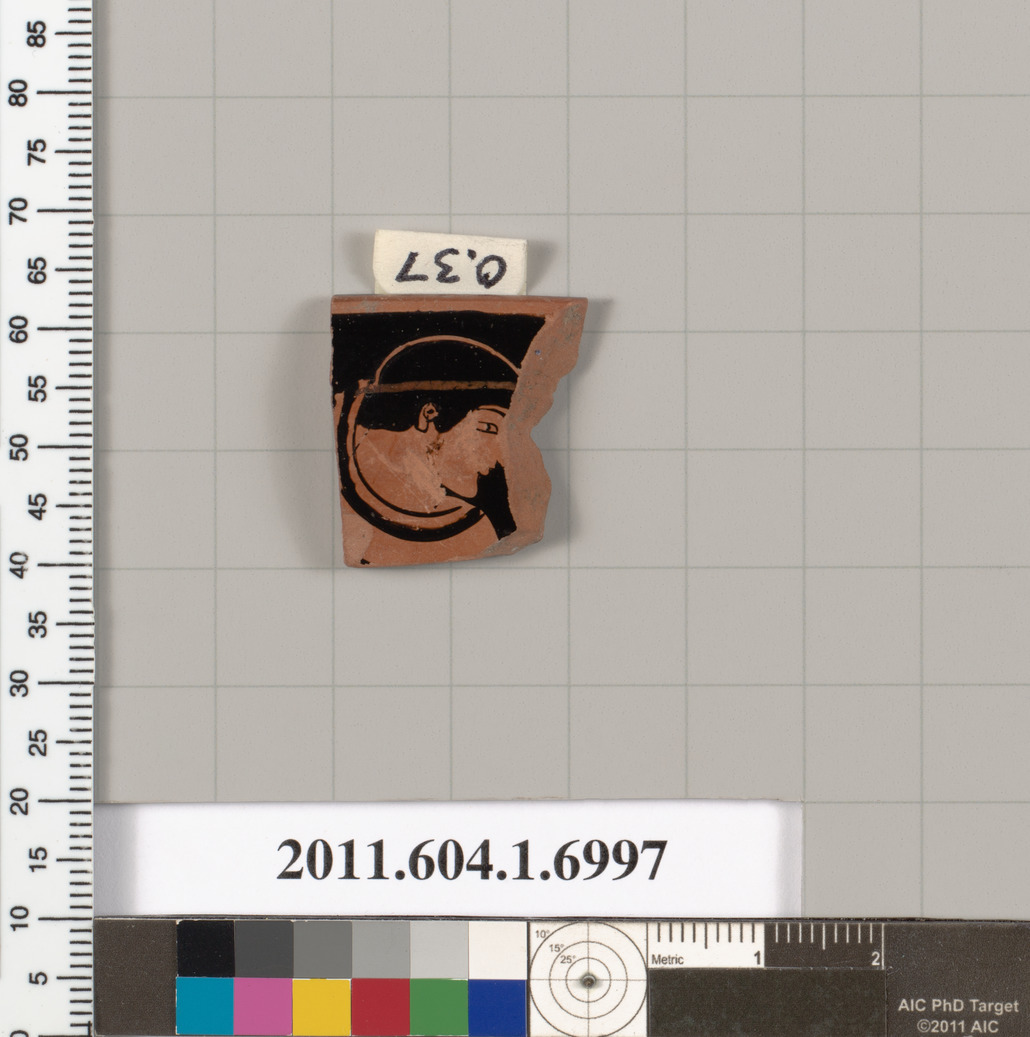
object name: kylix fragment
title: Terracotta rim fragment of a kylix (drinking cup)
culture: greek, attic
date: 500-480 BCE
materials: terracotta